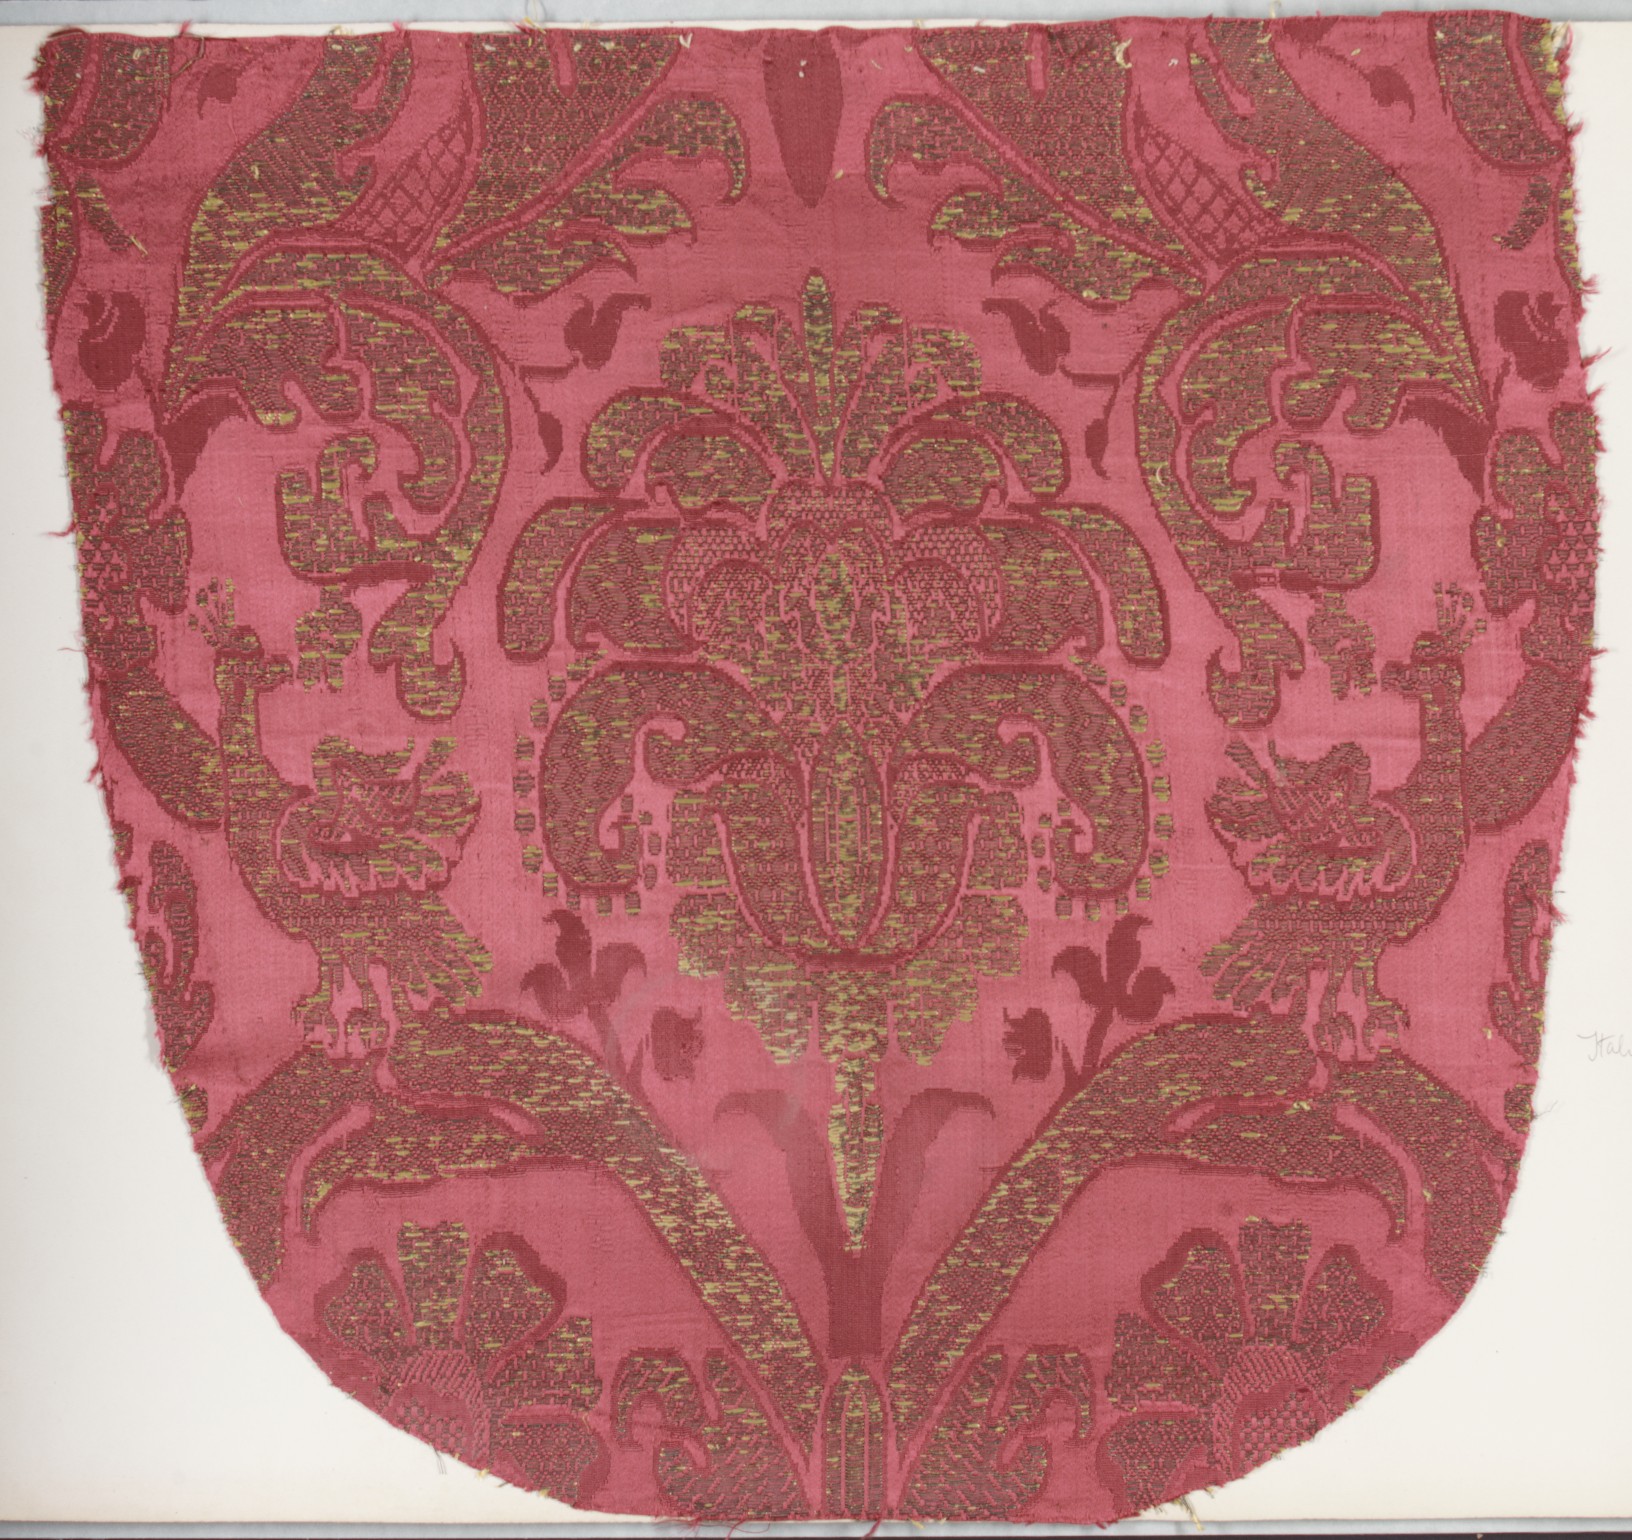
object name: fragment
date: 1601-1700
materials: metal thread, silk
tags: birds,flowers